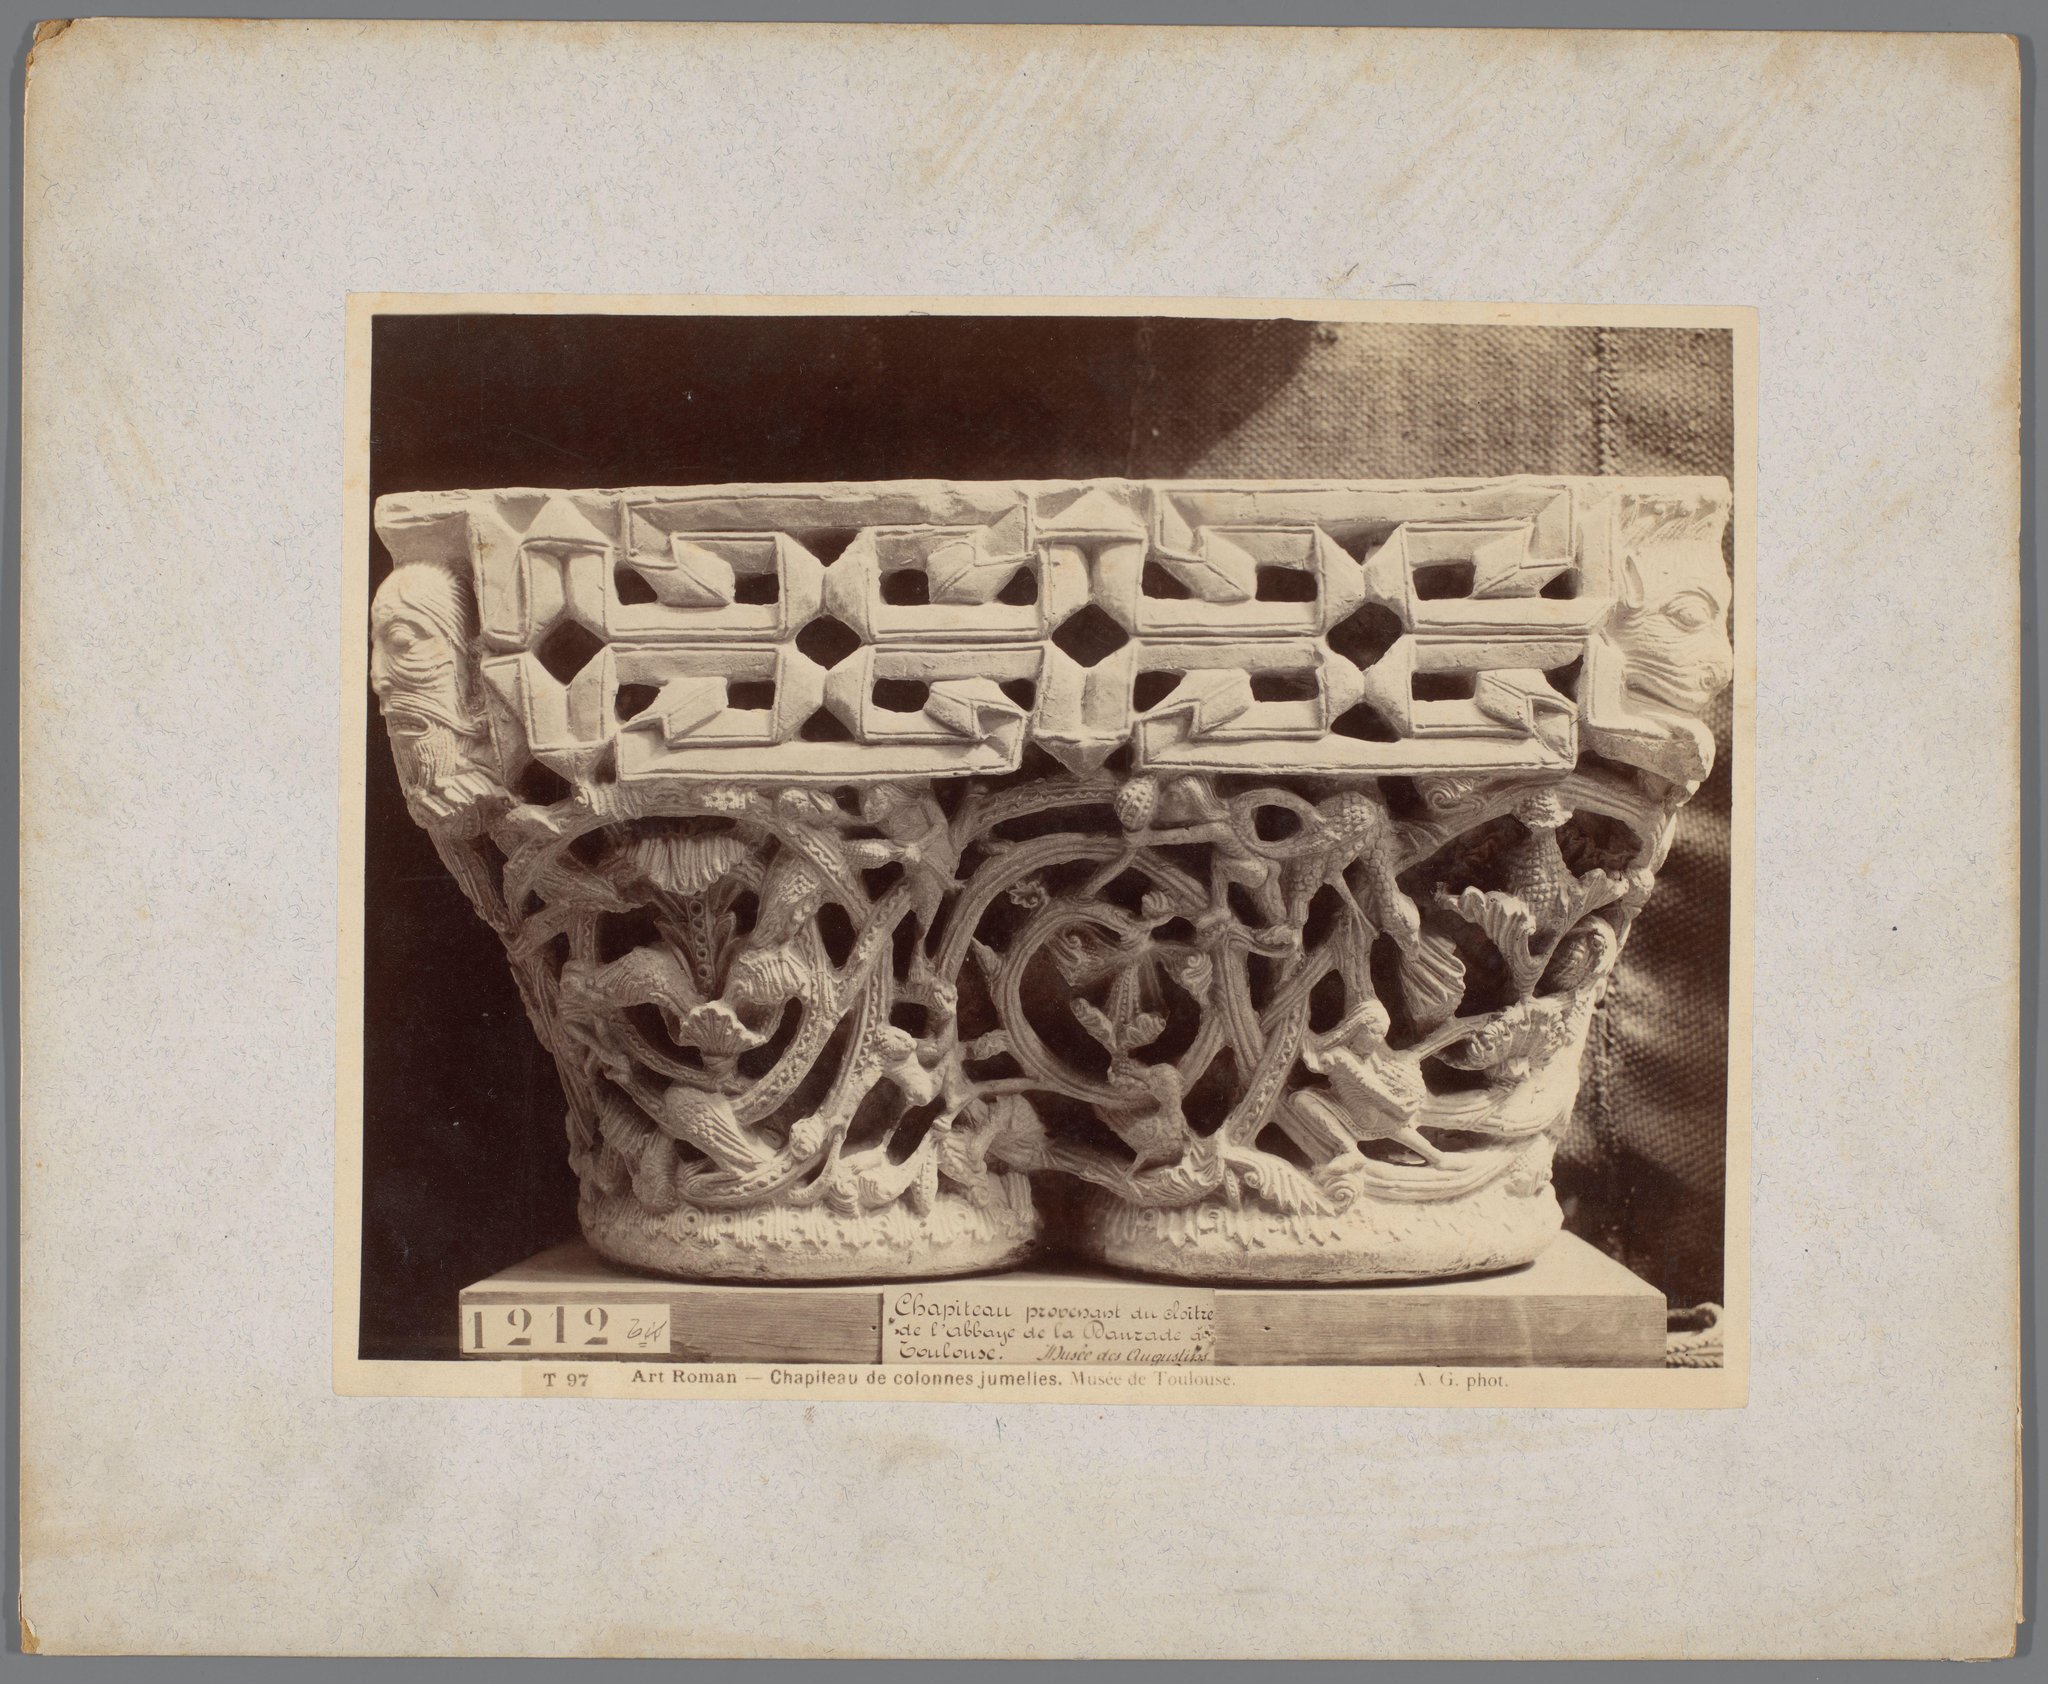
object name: photograph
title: Kapiteel van een dubbele zuil van het Daurade klooster in Toulouse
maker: adolphe giraudon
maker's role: publisher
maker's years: 1849-1929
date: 1850-1900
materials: cardboard, photographic support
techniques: albumen print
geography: paris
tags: capital (~ column, pillar)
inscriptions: number: ‘T 97’, workshop stamp: ‘A. Giraudon/ Éditeur/ 15. R. Bonaparte. Paris’, inscription: ‘Musée de Toulouse. A. G. phot.’, collector's mark: ‘RIJKS-NORMAALSCHOOL voor TEEKENONDERWIJZERS. AMSTERDAM’